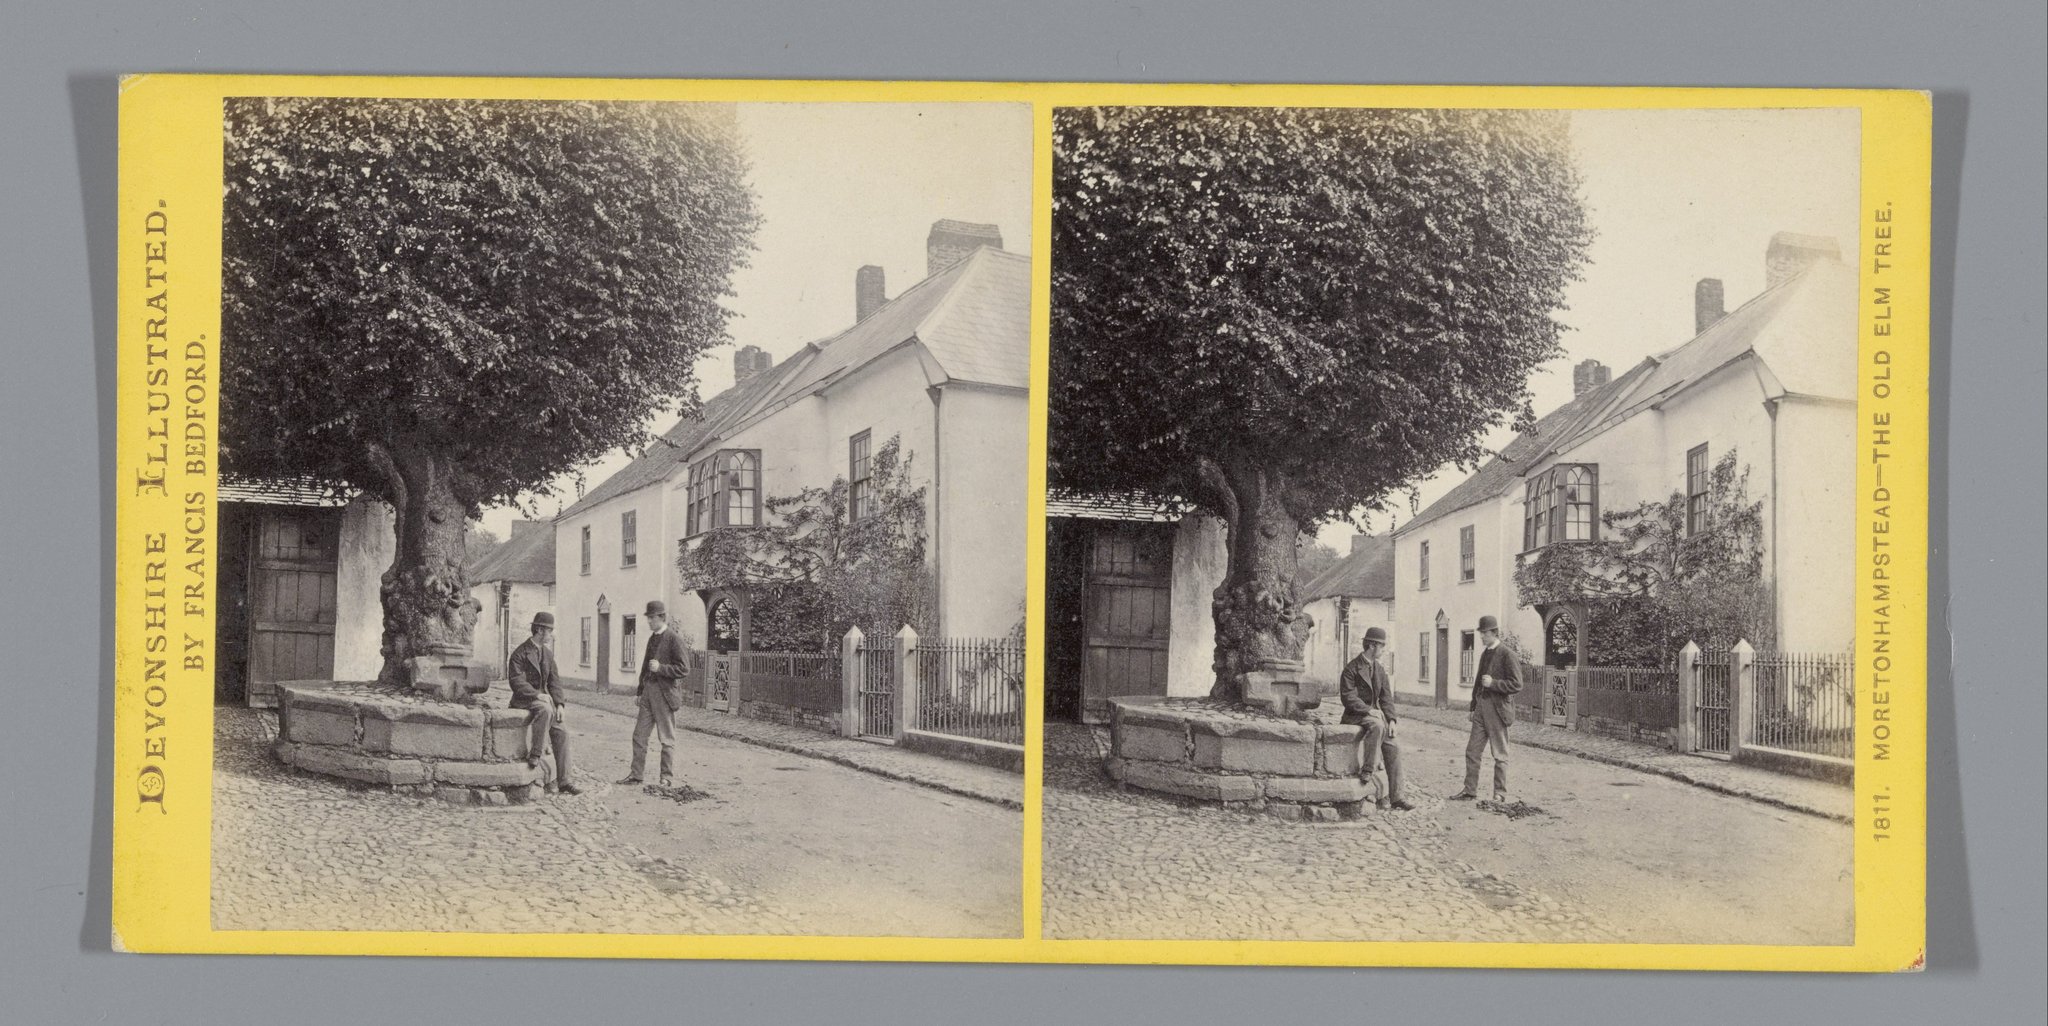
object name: stereograph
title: Iep op een plein te Moretonhampstead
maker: francis bedford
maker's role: print maker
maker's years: 1815-1894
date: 1850-1880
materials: cardboard, photographic support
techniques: albumen print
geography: moretonhampstead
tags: trees: elm, village square, place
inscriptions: inscription: ‘Devonshire Illustrated. by Francis Bedford.’, number: ‘1811.’